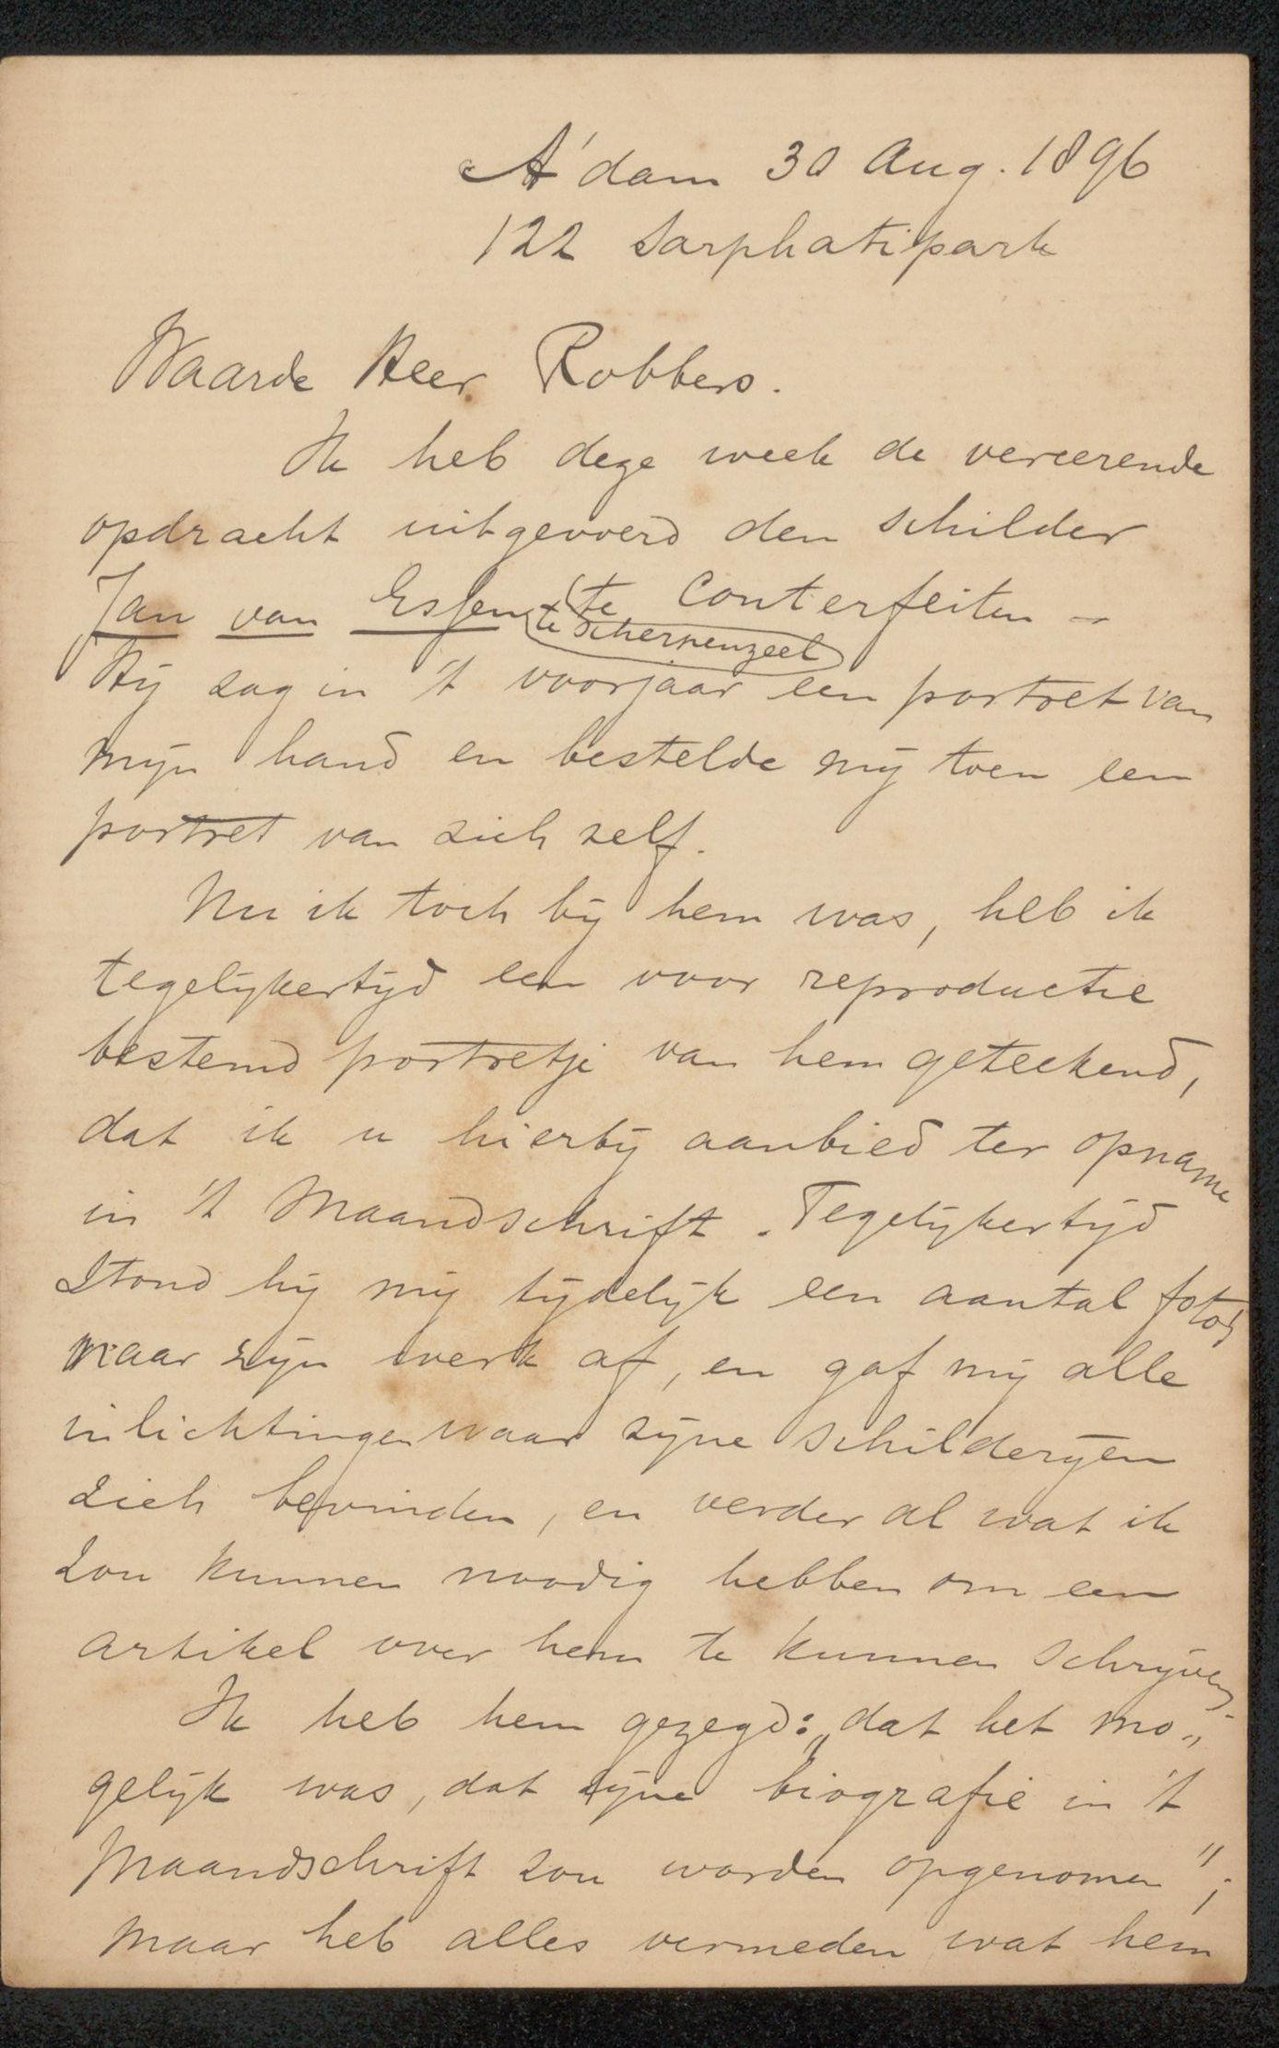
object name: letter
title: Brief aan Herman Robbers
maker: heinrich m. krabbé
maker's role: draughtsman, print maker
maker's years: 1868-1931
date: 1896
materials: ink, paper, pencil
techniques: pen, writing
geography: amsterdam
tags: print maker, jan van essen, herman robbers, the hague, painter, draughtsman, philip zilcken, photography, cinematography, painting (including book-illumination, miniature-painting), exhibition ~ art, historical persons (portraits and scenes from the life)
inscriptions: collector's mark: ‘RPK’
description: Brief bevat aantekeningen van Philip Zilcken.